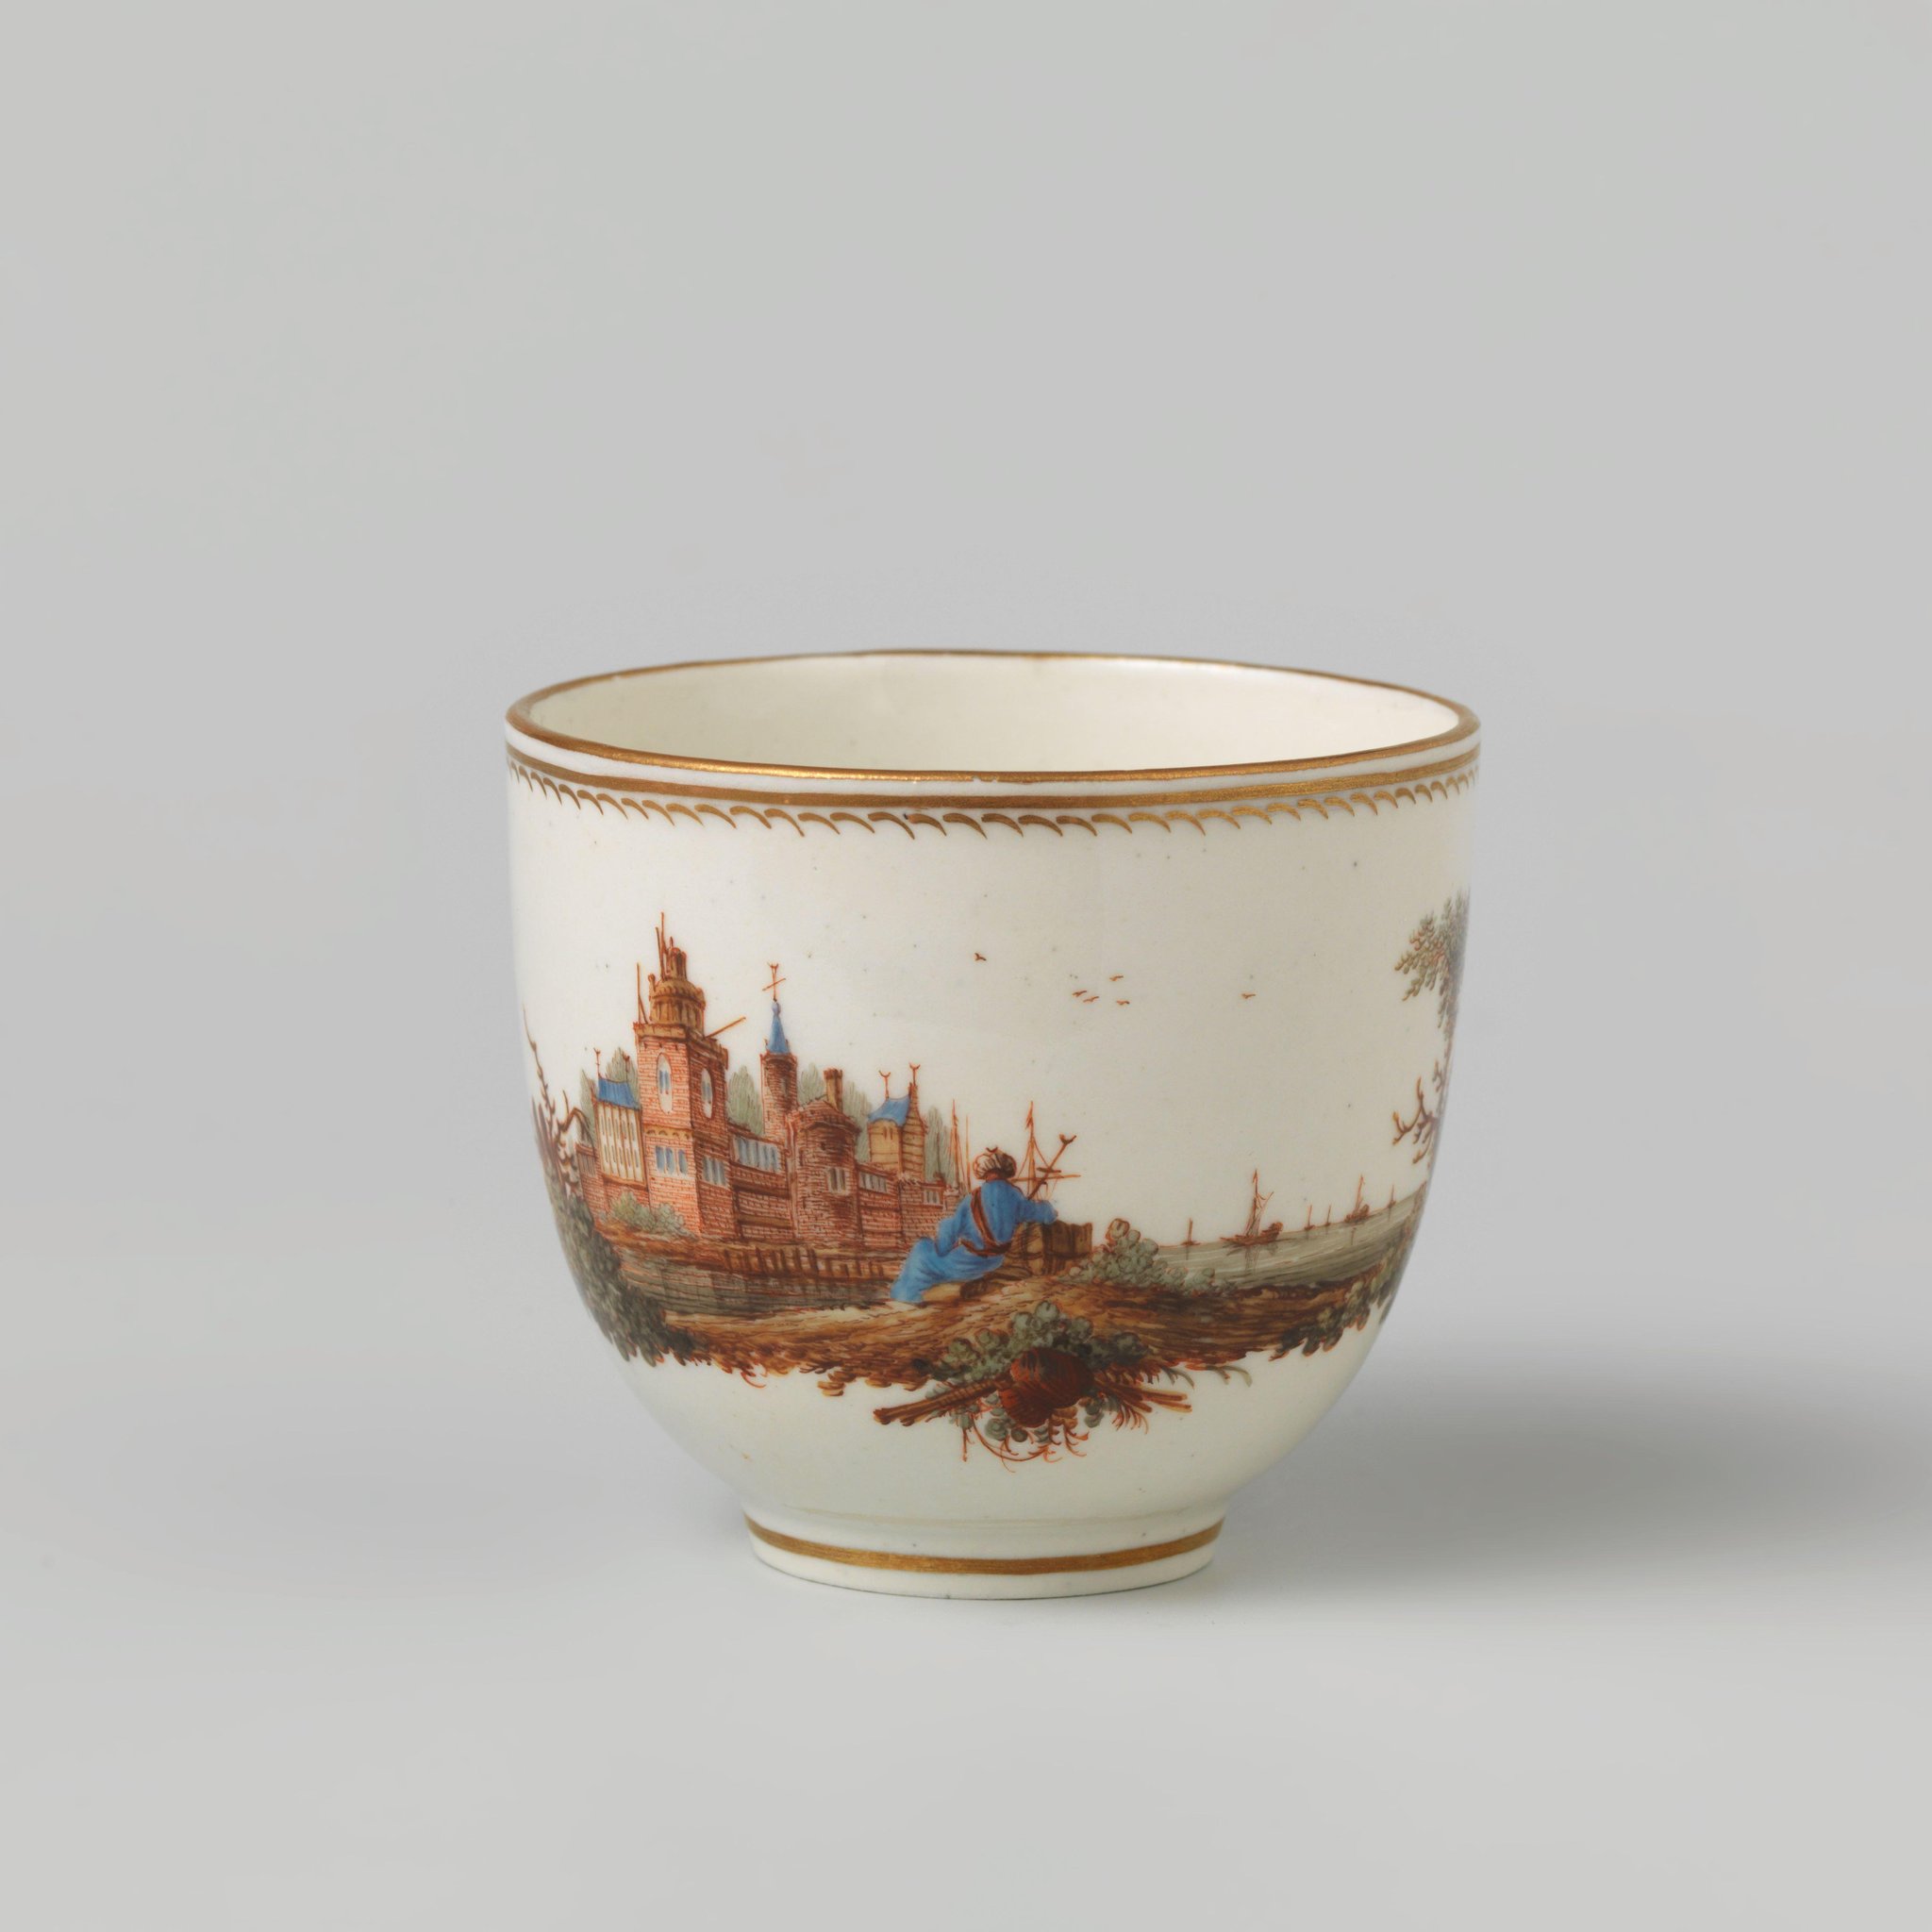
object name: cup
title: Kop, beschilderd met waterlandschap met kasteel/paleis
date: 1778-1782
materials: porcelain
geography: loosdrecht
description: Kop van porselein, veelkleurig beschilderd met waterlandschap in groen en bruin met figuren in blauw, roodbruin en paars aan de oever en met een groot kasteel/paleis aan de overkant met lichtblauwe ramen en daken. Gouden biezen langs de randen, ook het oor is versierd in goud.